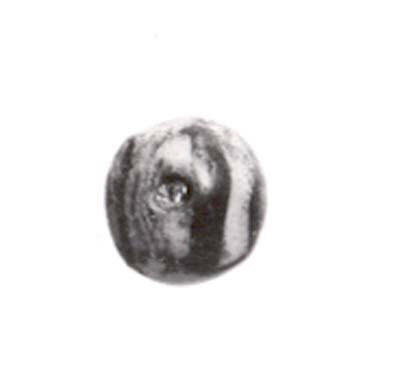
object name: bead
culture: sasanian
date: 201-700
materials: glass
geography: iran